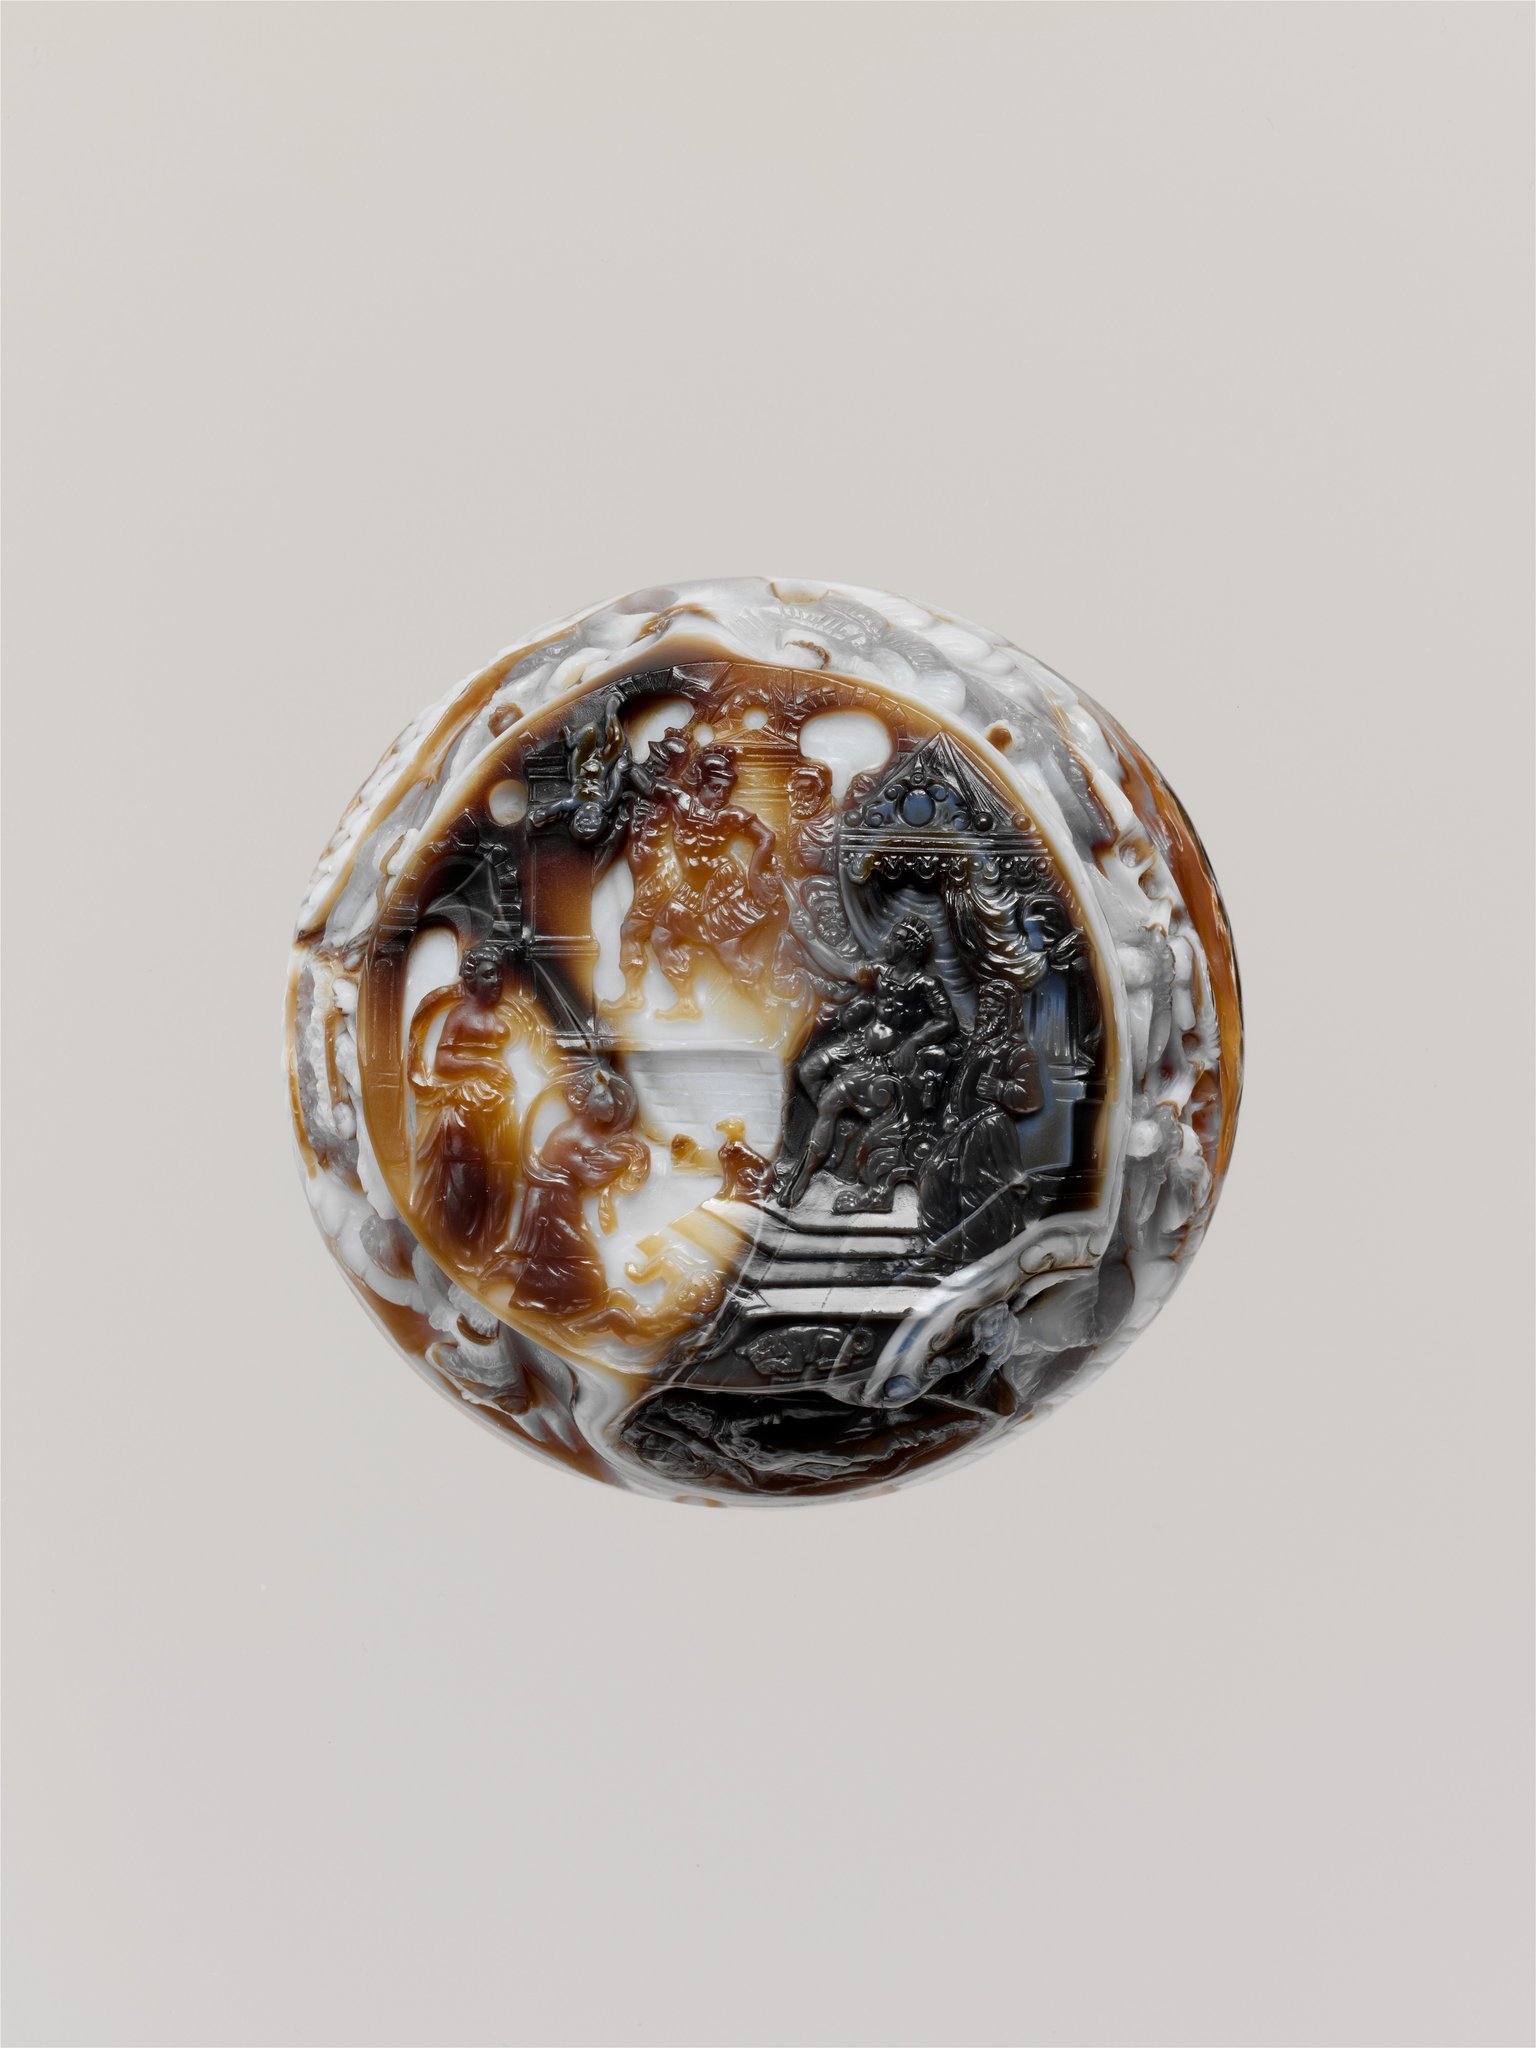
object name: cameo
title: The Judgment of Solomon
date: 1534-1566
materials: stone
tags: men,women